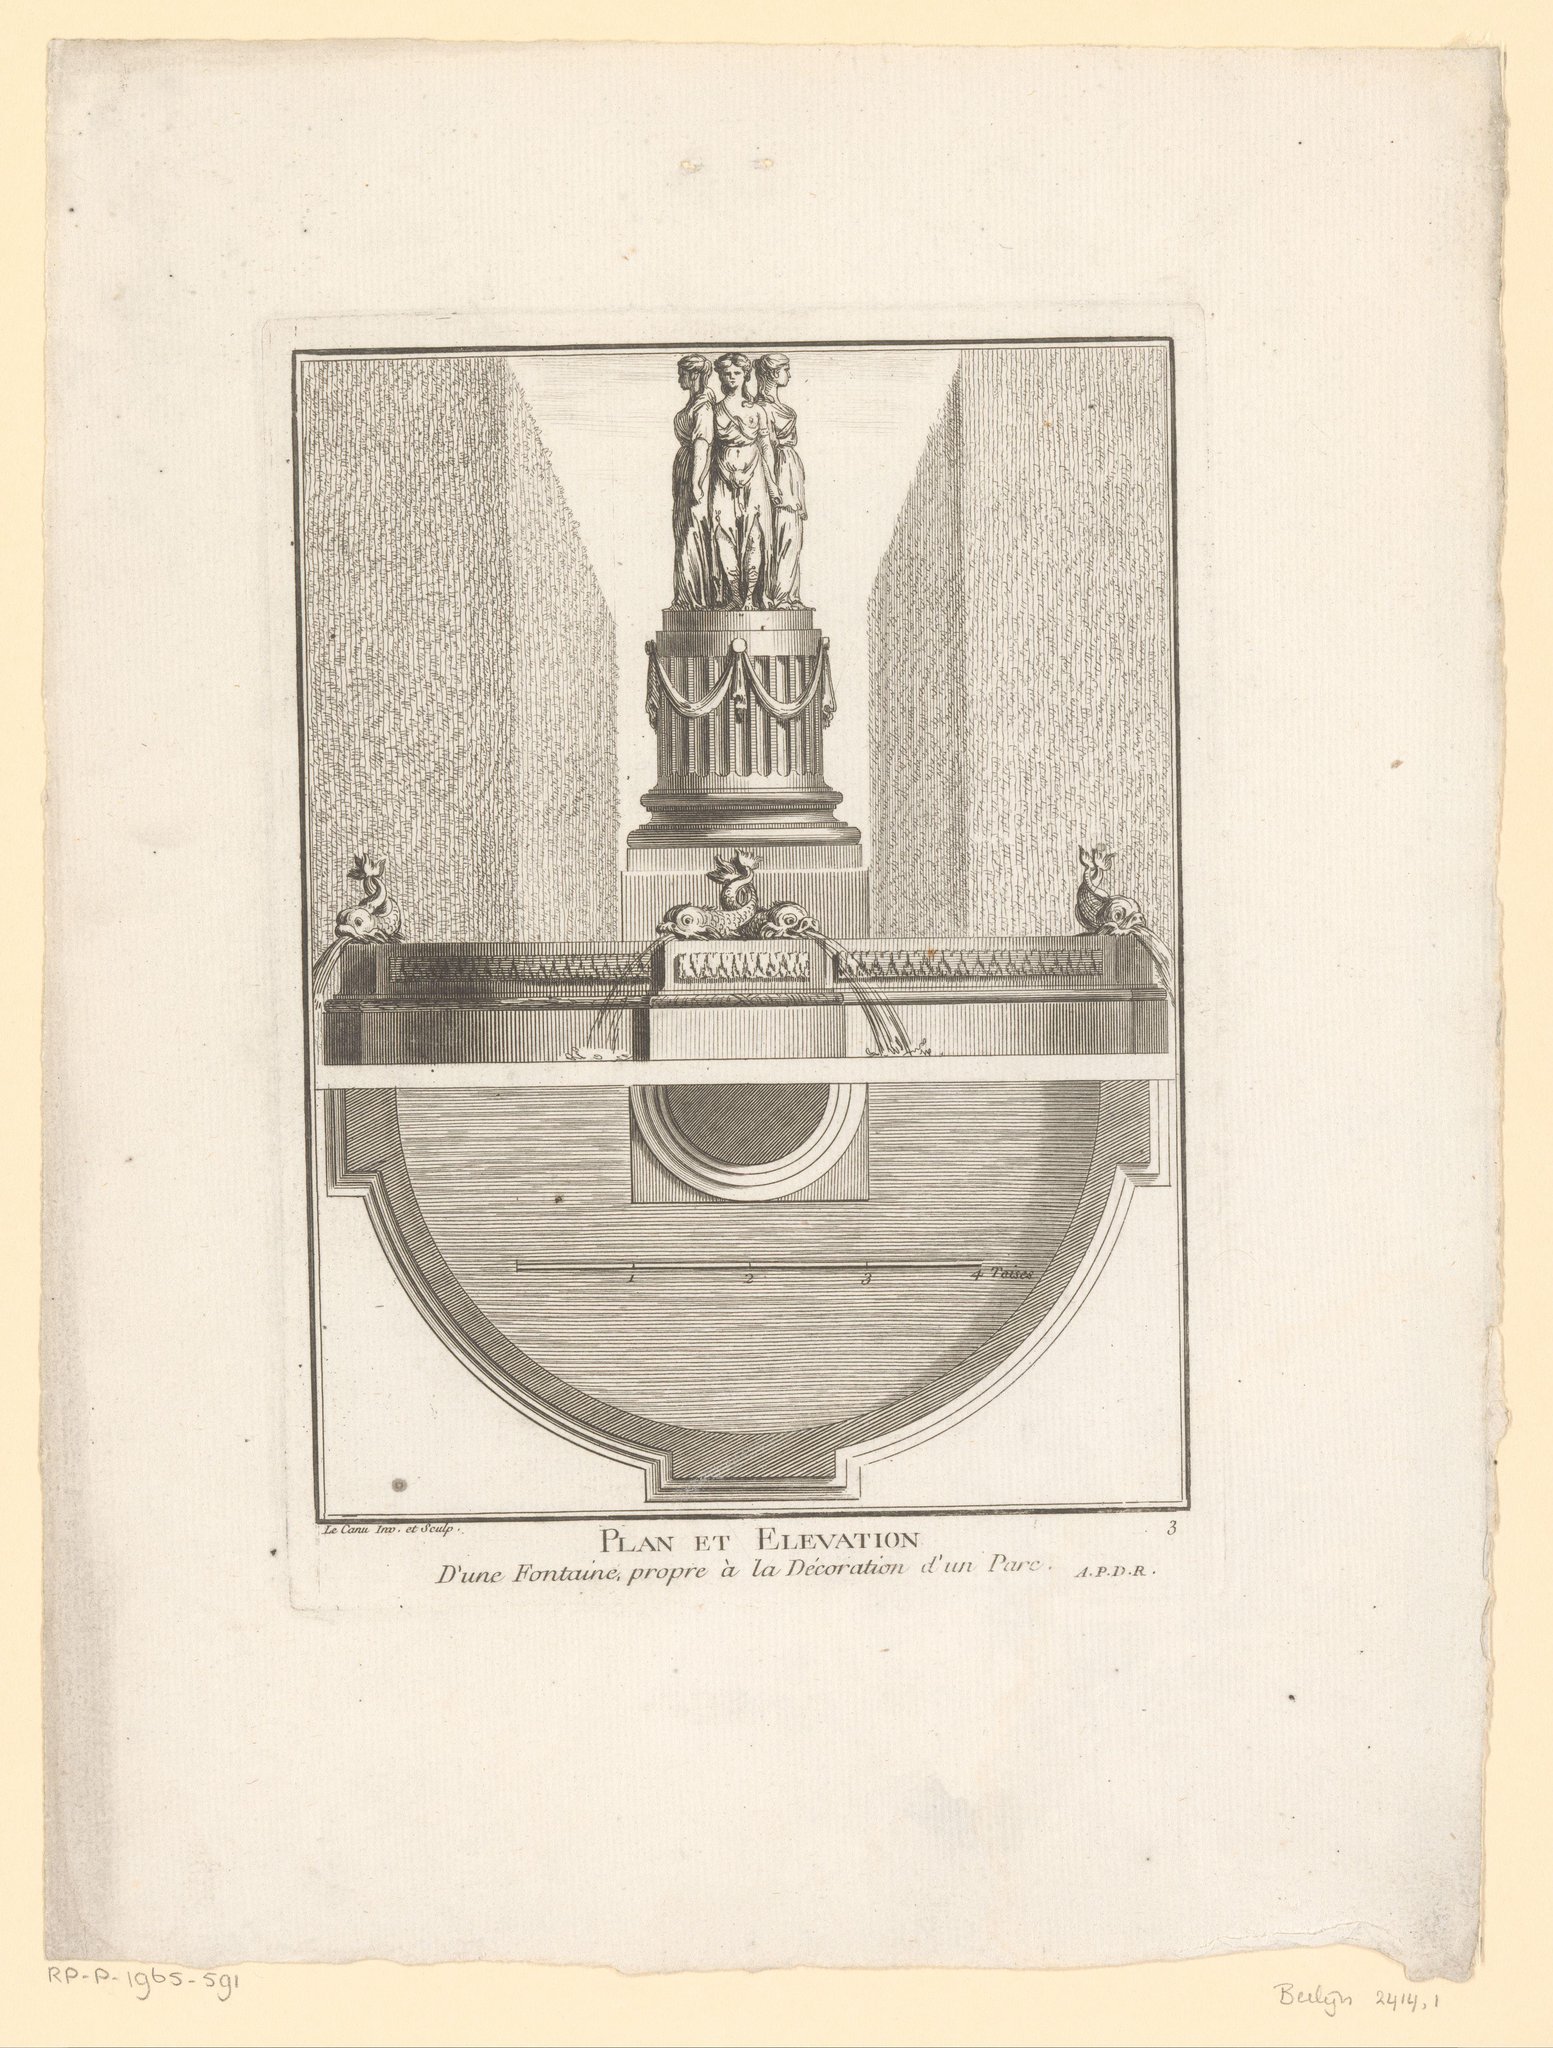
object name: ornament print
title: Fontein met dolfijnen en vrouwen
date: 1778-1782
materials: paper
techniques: etching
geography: paris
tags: dolphin ~ ornament, standing figure - aa - female human figure, ornamental fountain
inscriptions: collector's mark: Lugt 2228, collector's mark: Lugt 2760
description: Vooraanzicht en plattegrond van een geornamenteerde fontein met vier dolfijnen en drie staande vrouwen op een zuil.